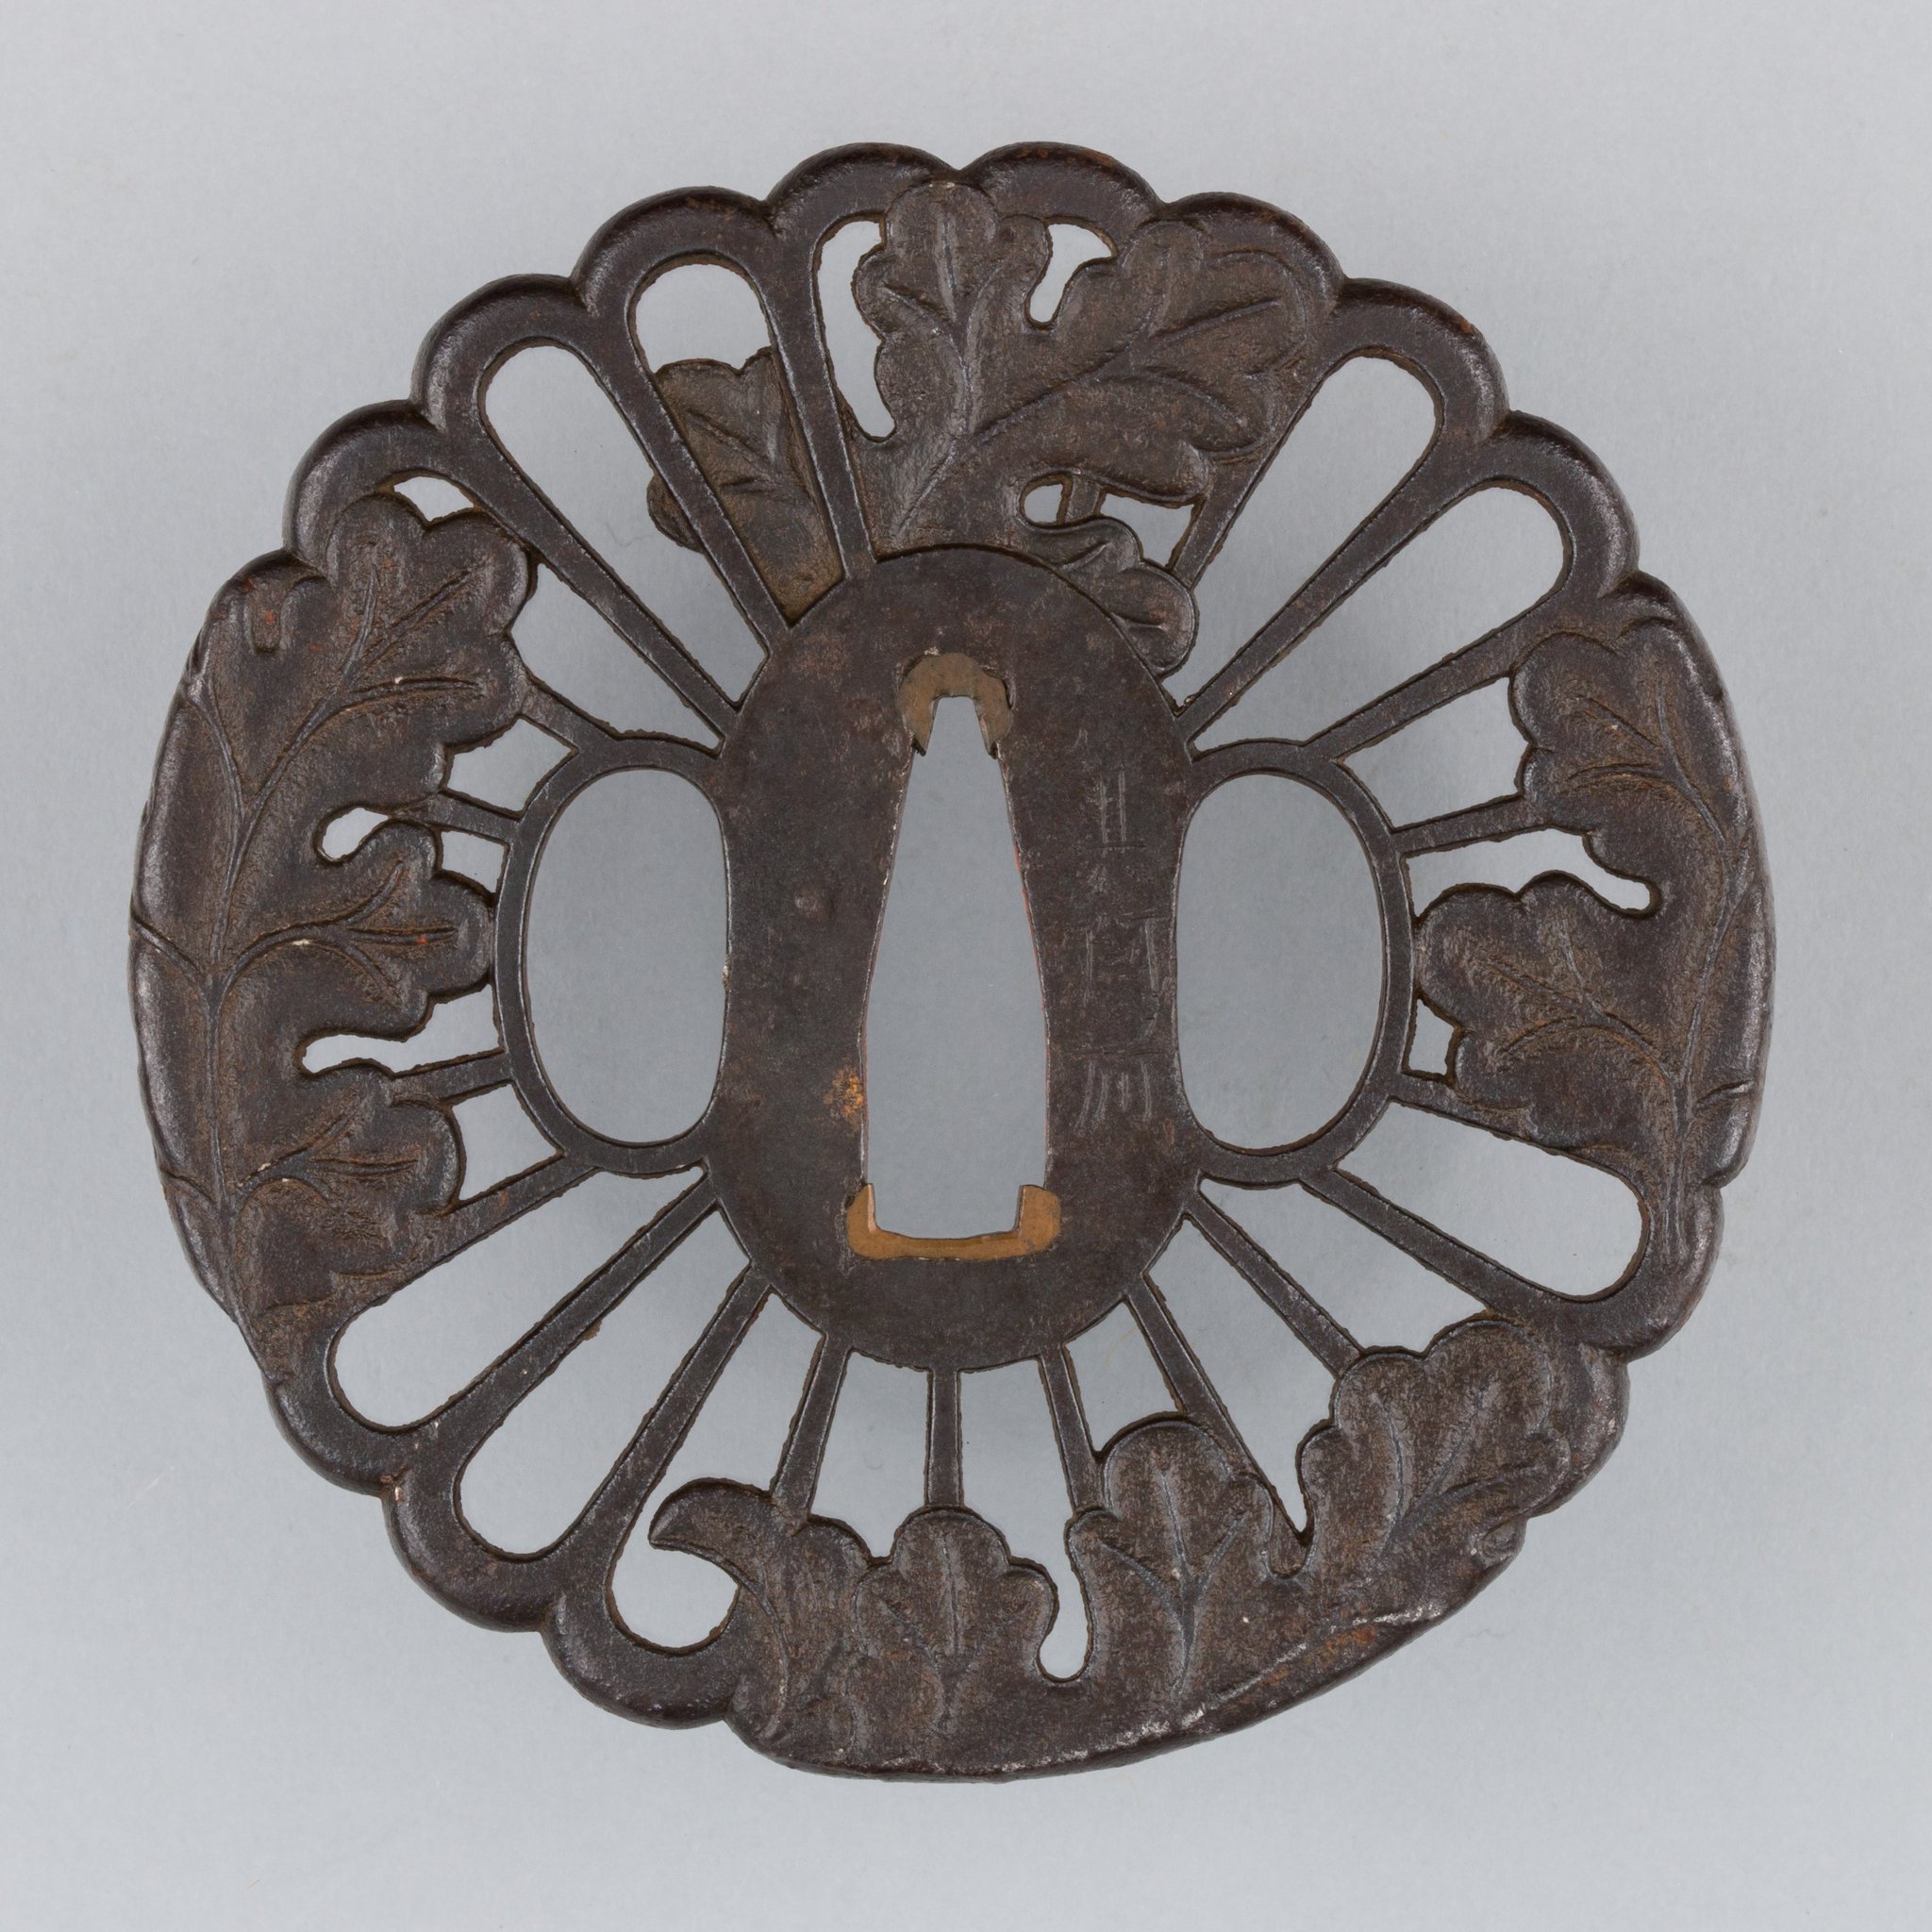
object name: sword guard tsuba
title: Sword Guard (Tsuba)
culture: japanese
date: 1667-1700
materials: copper, iron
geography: japan